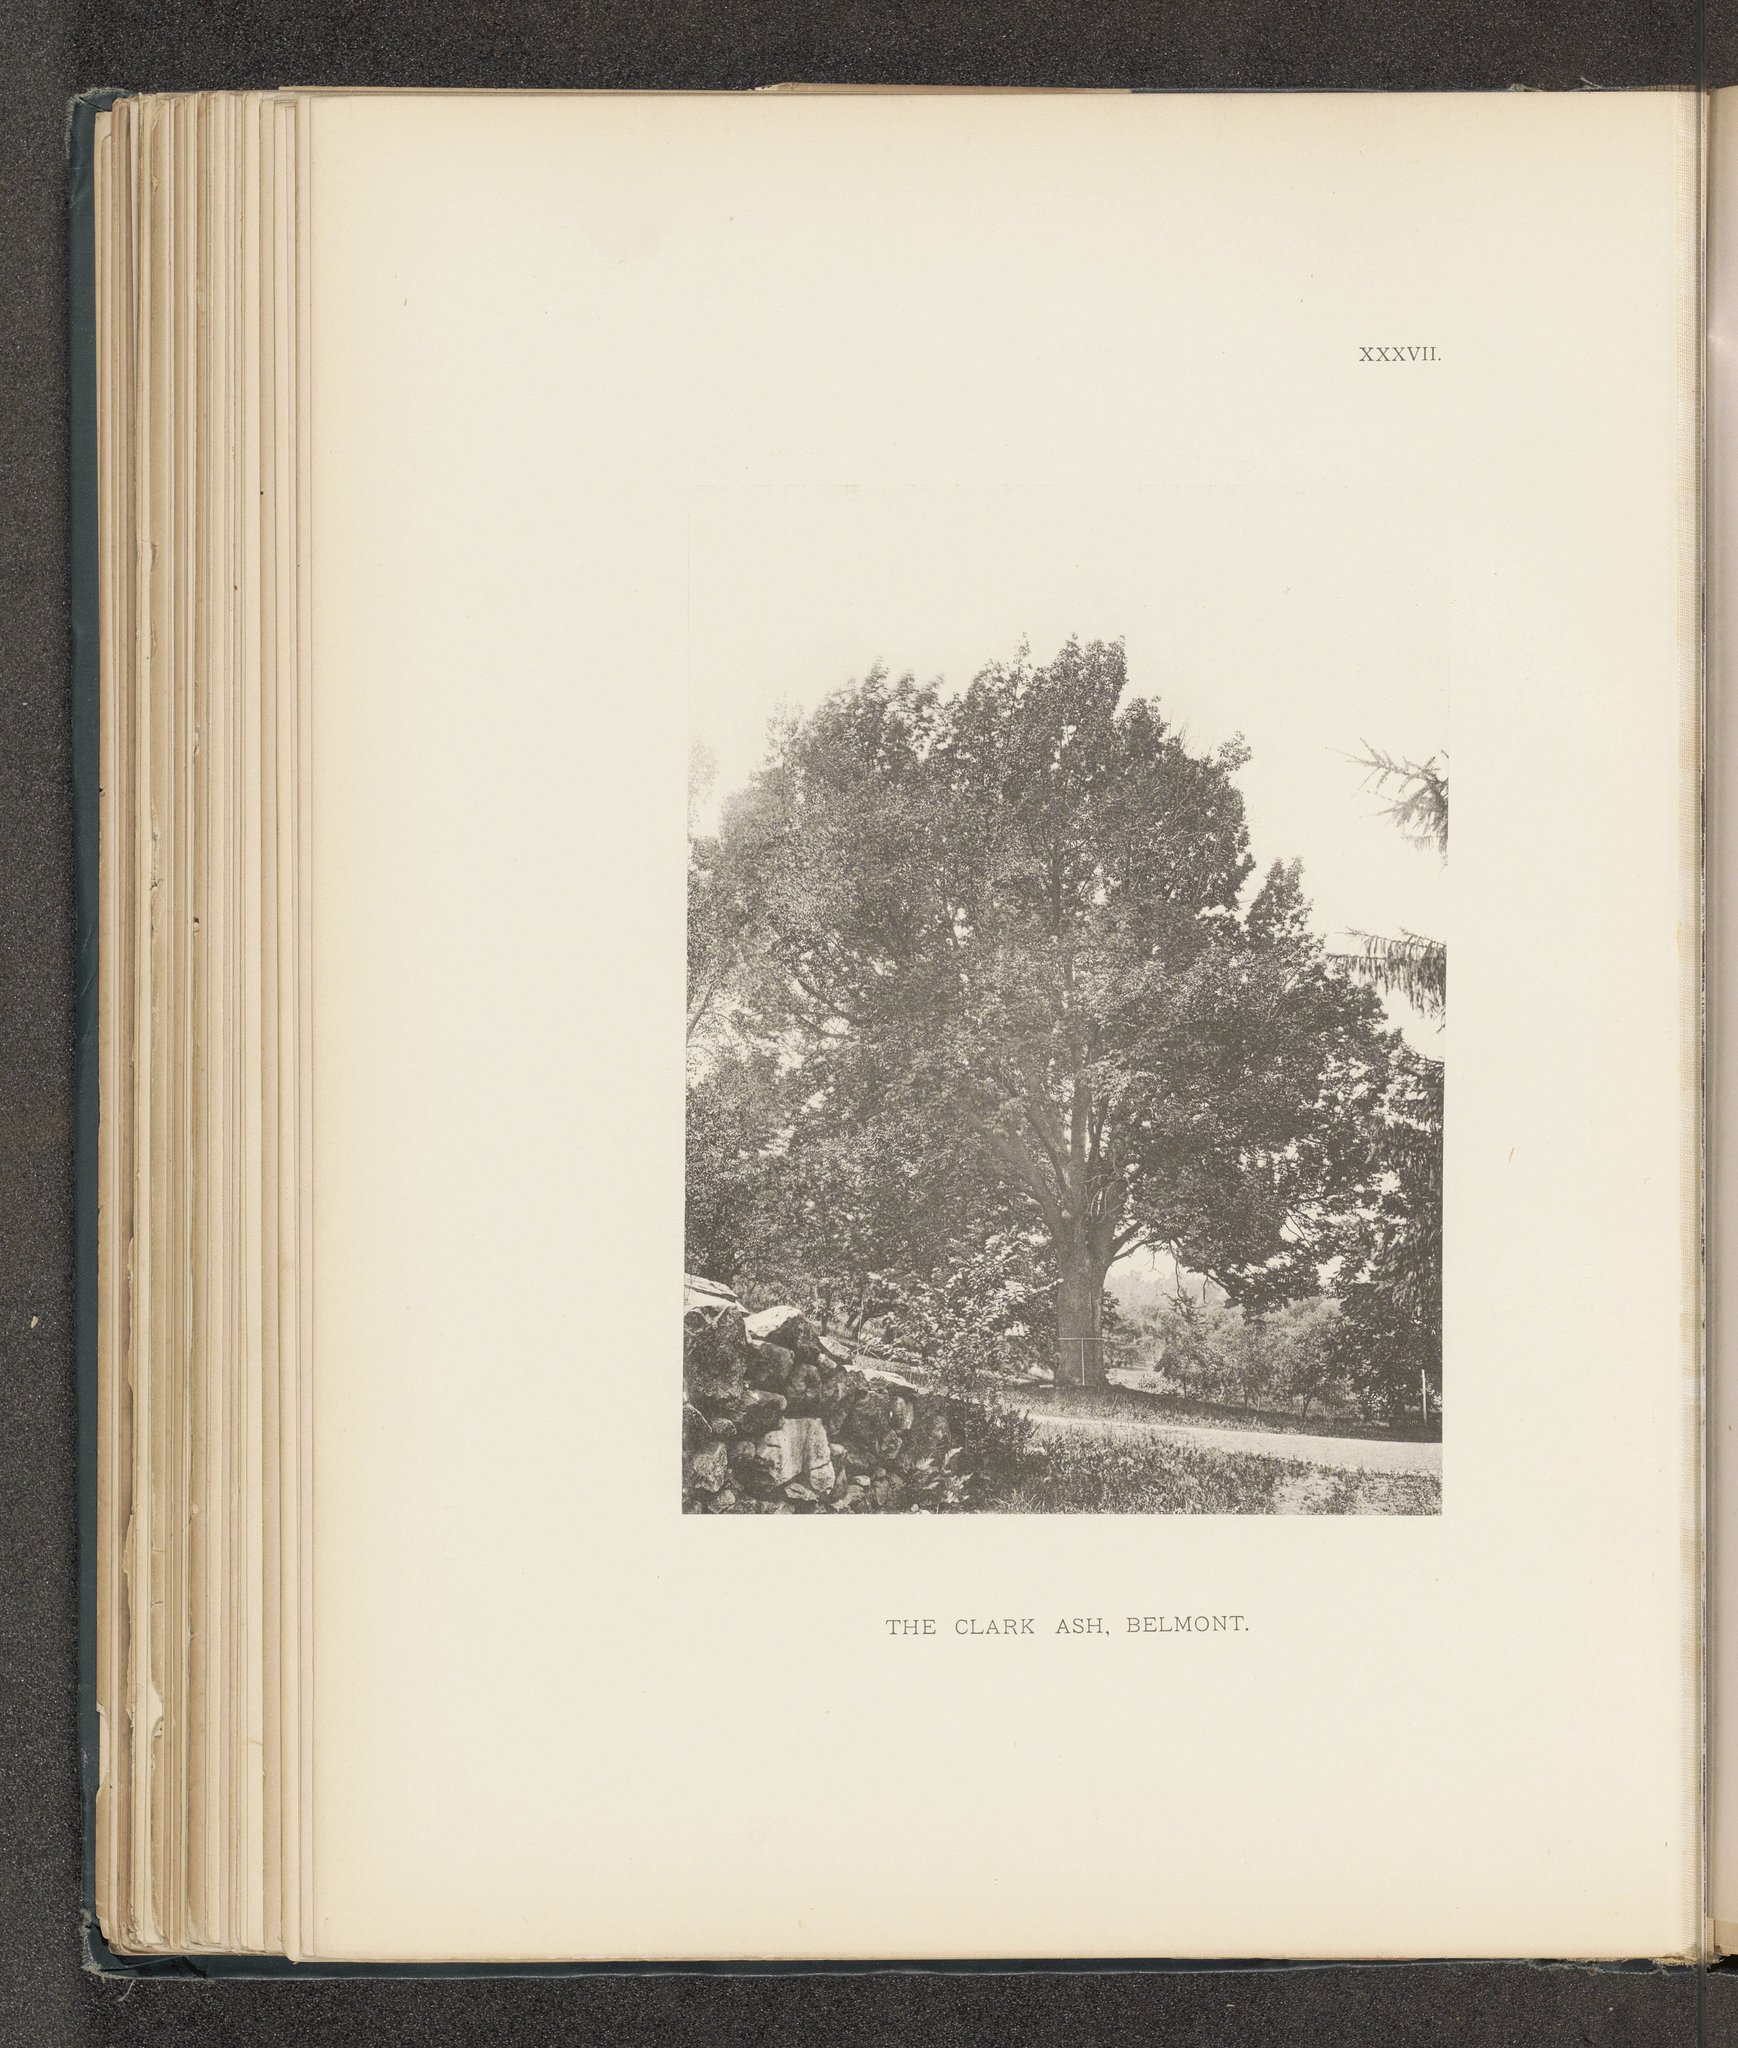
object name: page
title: The Clark ash, Belmont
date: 1880-1890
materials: paper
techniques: photograph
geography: united states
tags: trees: ash-tree, public road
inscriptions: number: ‘XXXVII.’